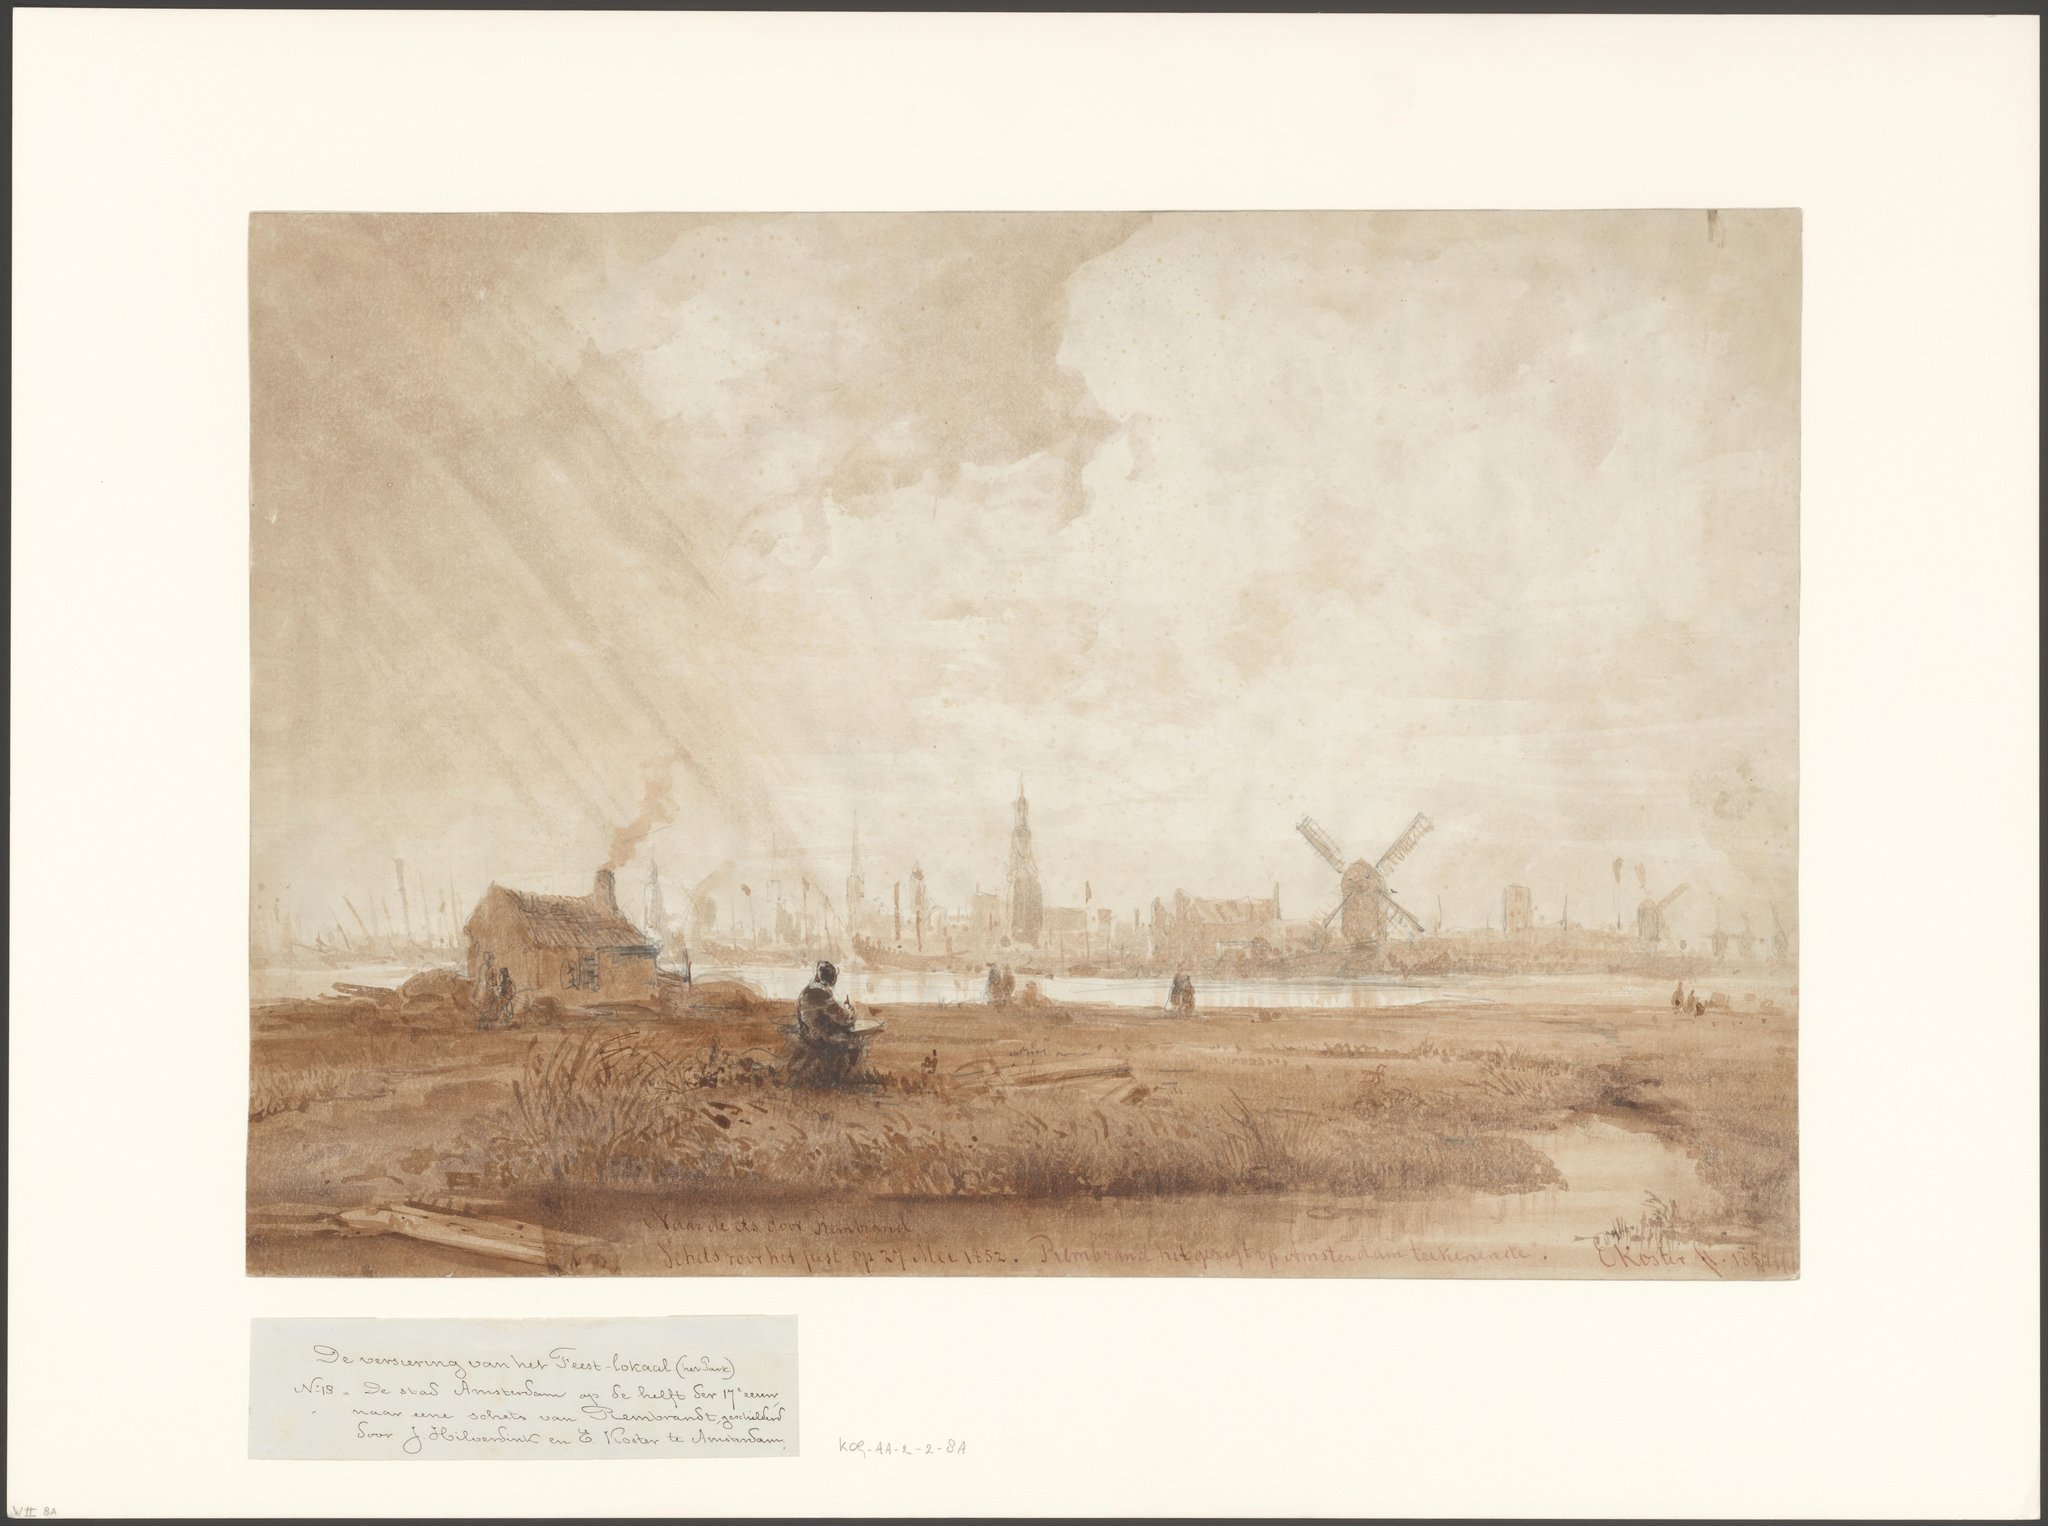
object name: drawing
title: Gezicht op een tekenende Rembrandt over Amsterdam uitkijkend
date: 1852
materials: ink, paper, pencil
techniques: brush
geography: amsterdam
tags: tower, clock tower ~ monumental adornment, city-view in general; 'veduta', river, draughtsman at work, windmill in landscape, amsterdam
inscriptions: collector's mark: Lugt 800a, inscription: ‘Naar de ets (...) op Amsterdam teekenende.’, inscription: ‘van achteren’, inscription: ‘De versiering van (...) Koster te Amsterdam.’, signature and date: ‘E Koster ft 1852’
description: Tekening binnen de Atlas Van Eck ingedeeld op wijknummer 2.